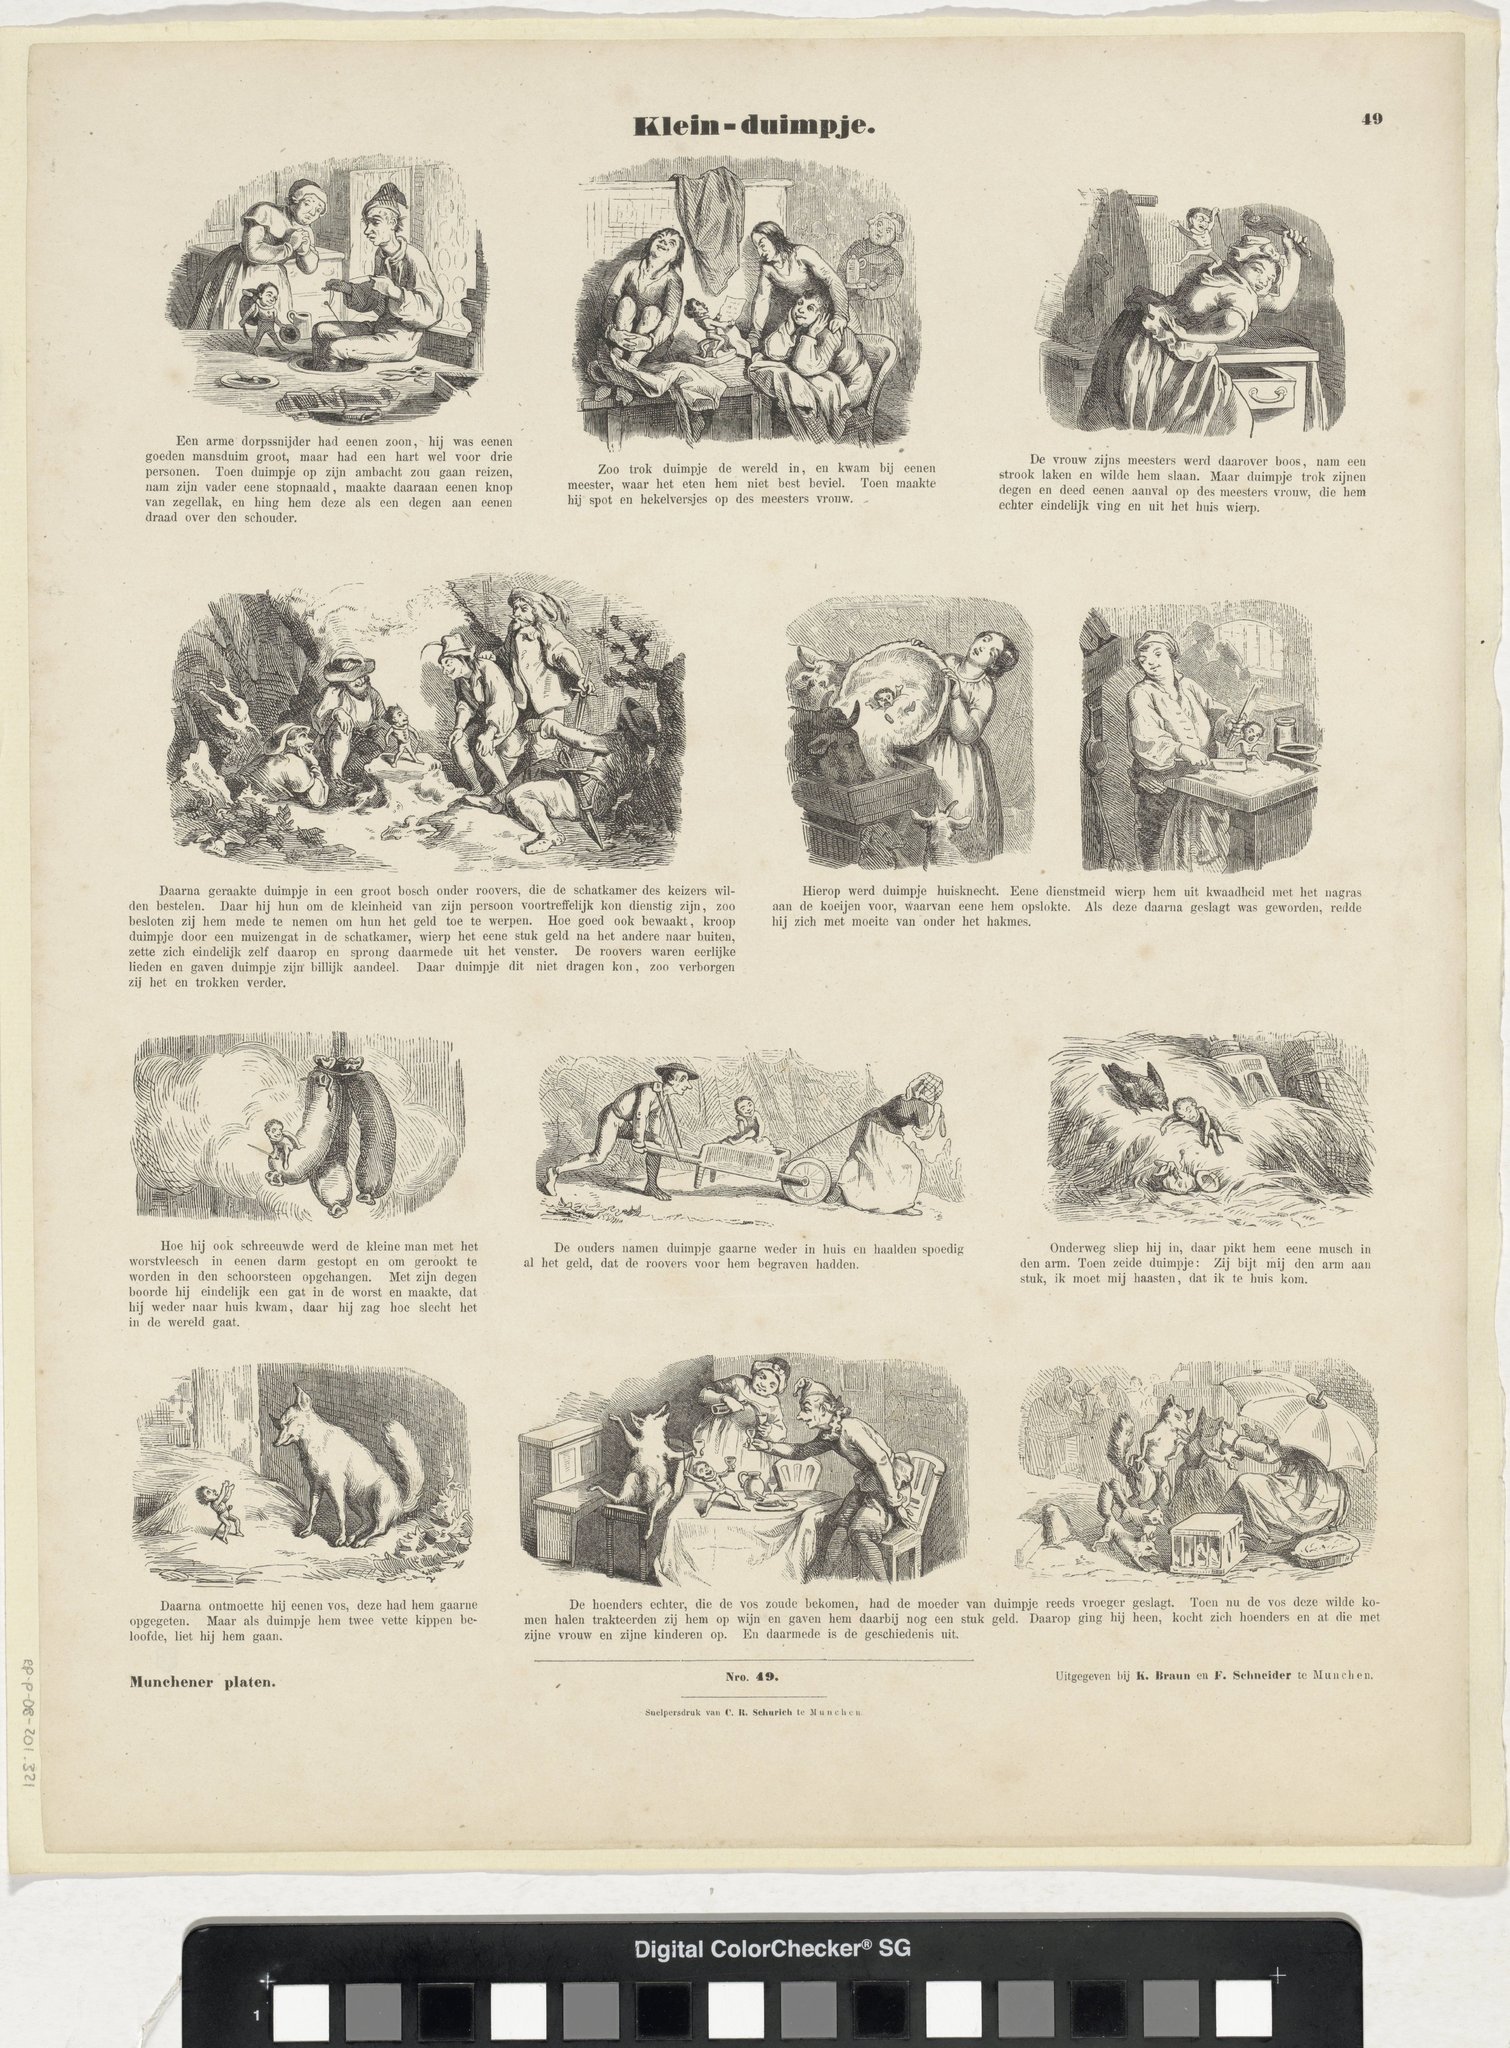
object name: print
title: Klein-duimpje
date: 1843-1920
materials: paper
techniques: letterpress printing, engraving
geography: munich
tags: tales and fairy tales: little thumbling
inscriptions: collector's mark: Lugt 2760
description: Blad met 12 voorstellingen over het sprookje van Klein Duimpje. Onder elke afbeelding een onderschrift. Genummerd midden onder: Nro. 49. Genummerd rechtsboven: 49.